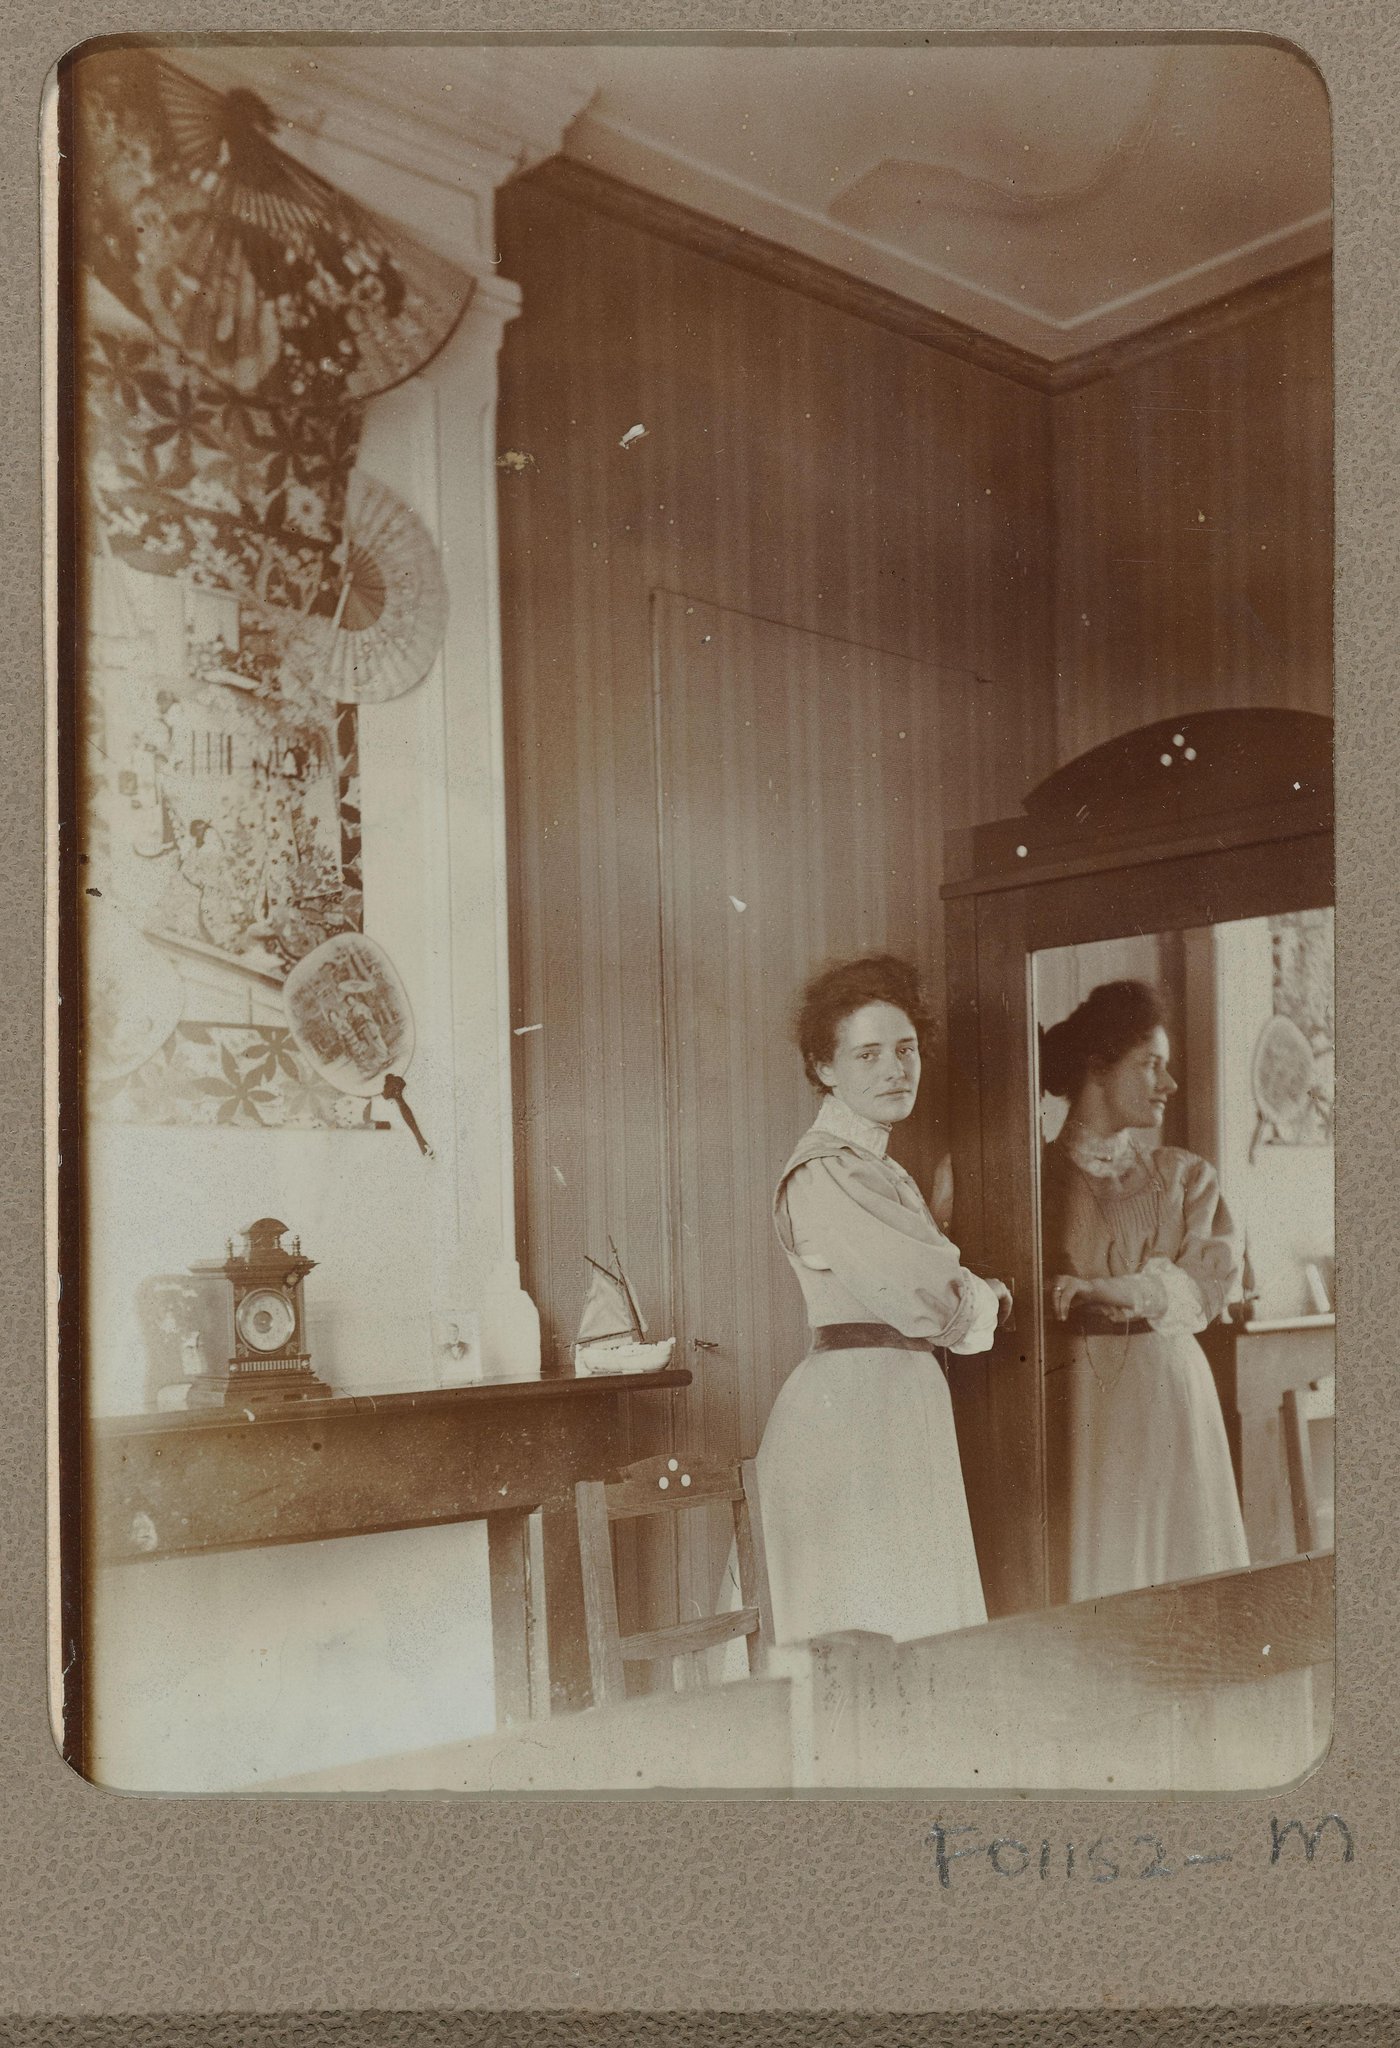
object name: album leaf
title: Portret van Charlotte Roelofs-van der Schilt staande voor een spiegelkast in een interieur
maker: christiaan otto roelofs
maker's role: fotograaf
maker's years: 1882-1970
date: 1909-1915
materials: photographic support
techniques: gelatin silver print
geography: netherlands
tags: amsterdam, historical persons - bb - woman, interior of the house, reflection (in a mirror)